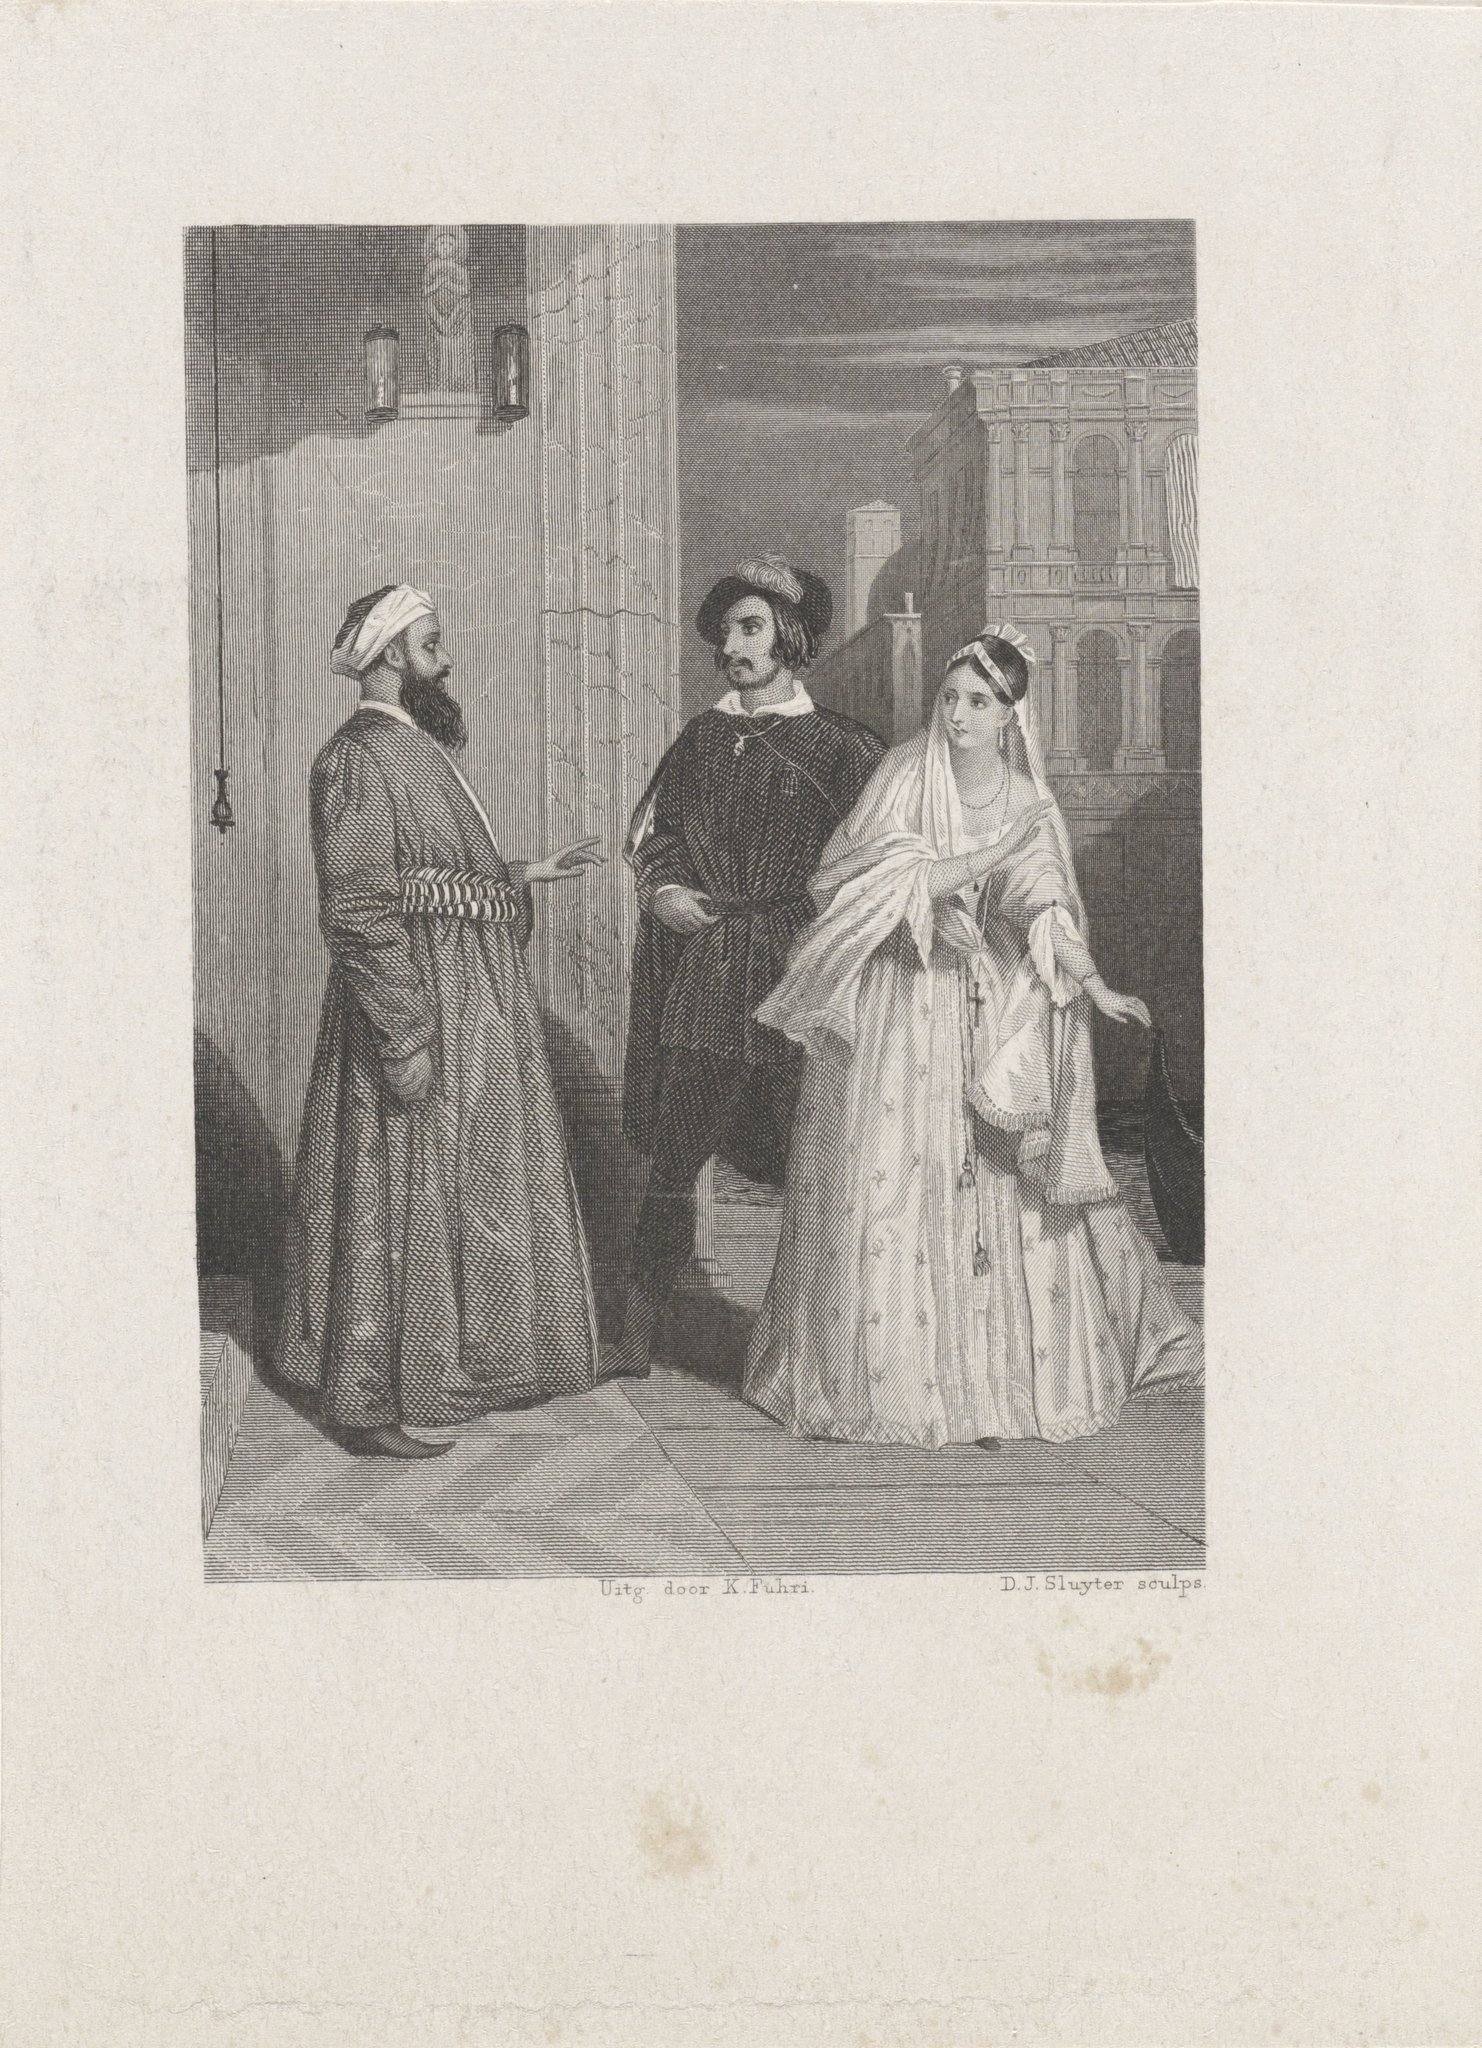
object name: book illustration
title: Stadsgezicht met Arabier en man met vrouw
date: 1849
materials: paper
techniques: engraving, etching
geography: the hague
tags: head-gear: turban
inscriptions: collector's mark: Lugt 2228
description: Prent komt voor in: J.I.D. Nepveu en S.J. van den Bergh (reds.). Aurora; jaarboekje voor 1849. Den Haag, K. Fuhri, 1849.